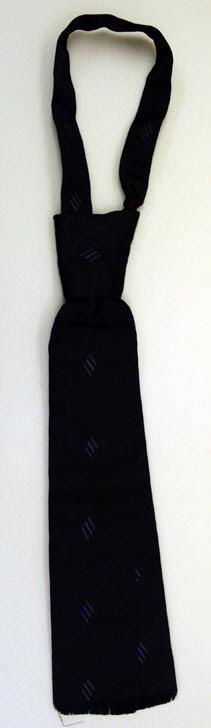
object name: cravat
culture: european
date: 1880-1889